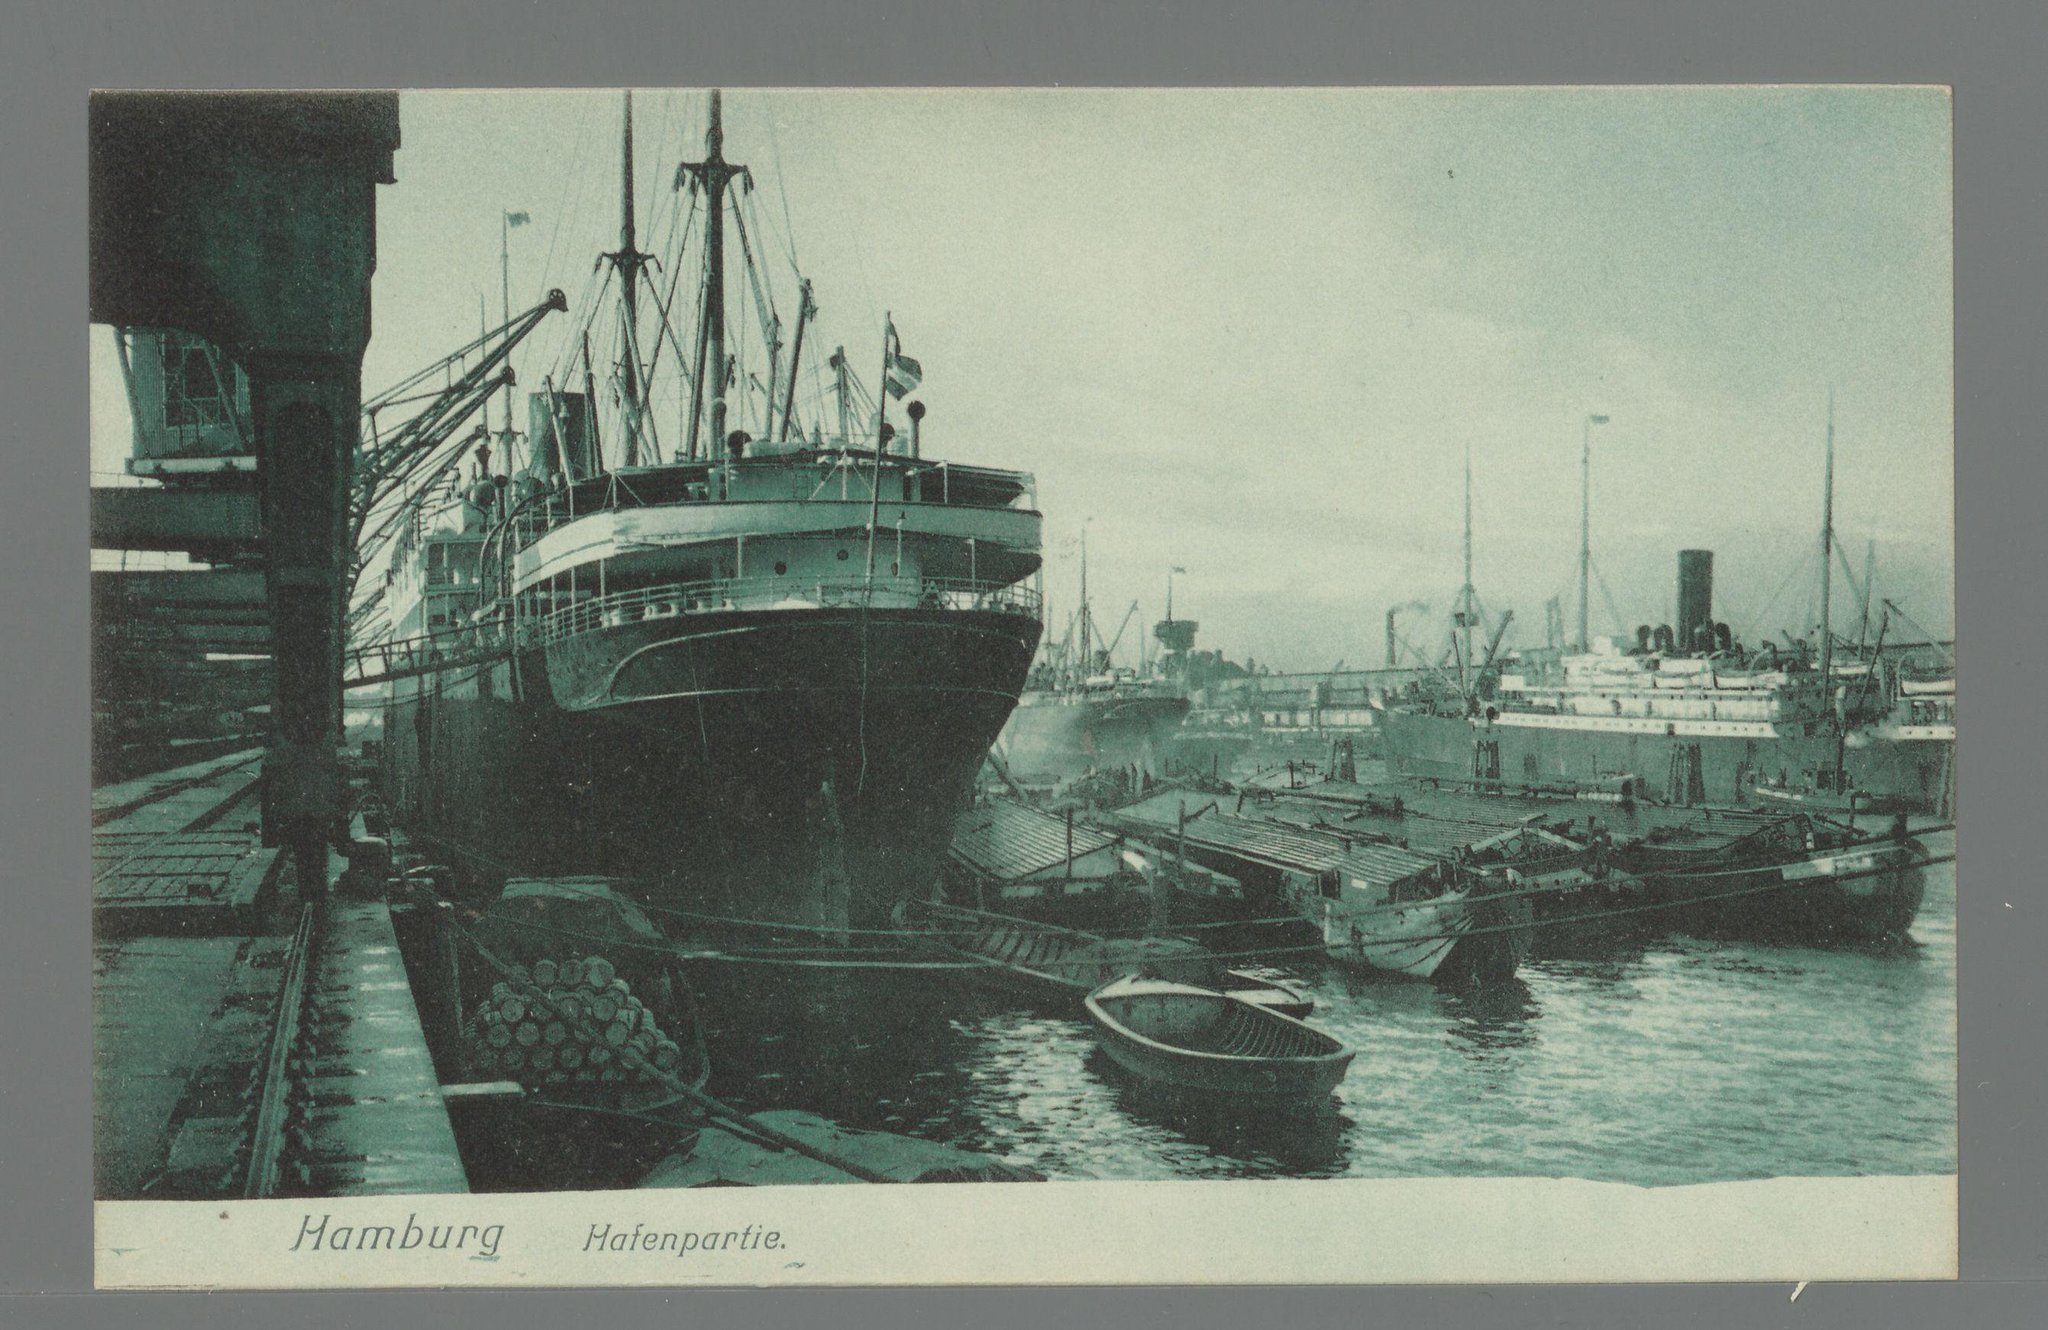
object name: ansichtkaart, prentbriefkaart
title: Hamburg. Hafenpartie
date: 1905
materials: cardboard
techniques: photograph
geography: hamburg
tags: harbour, ships (in general)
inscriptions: date